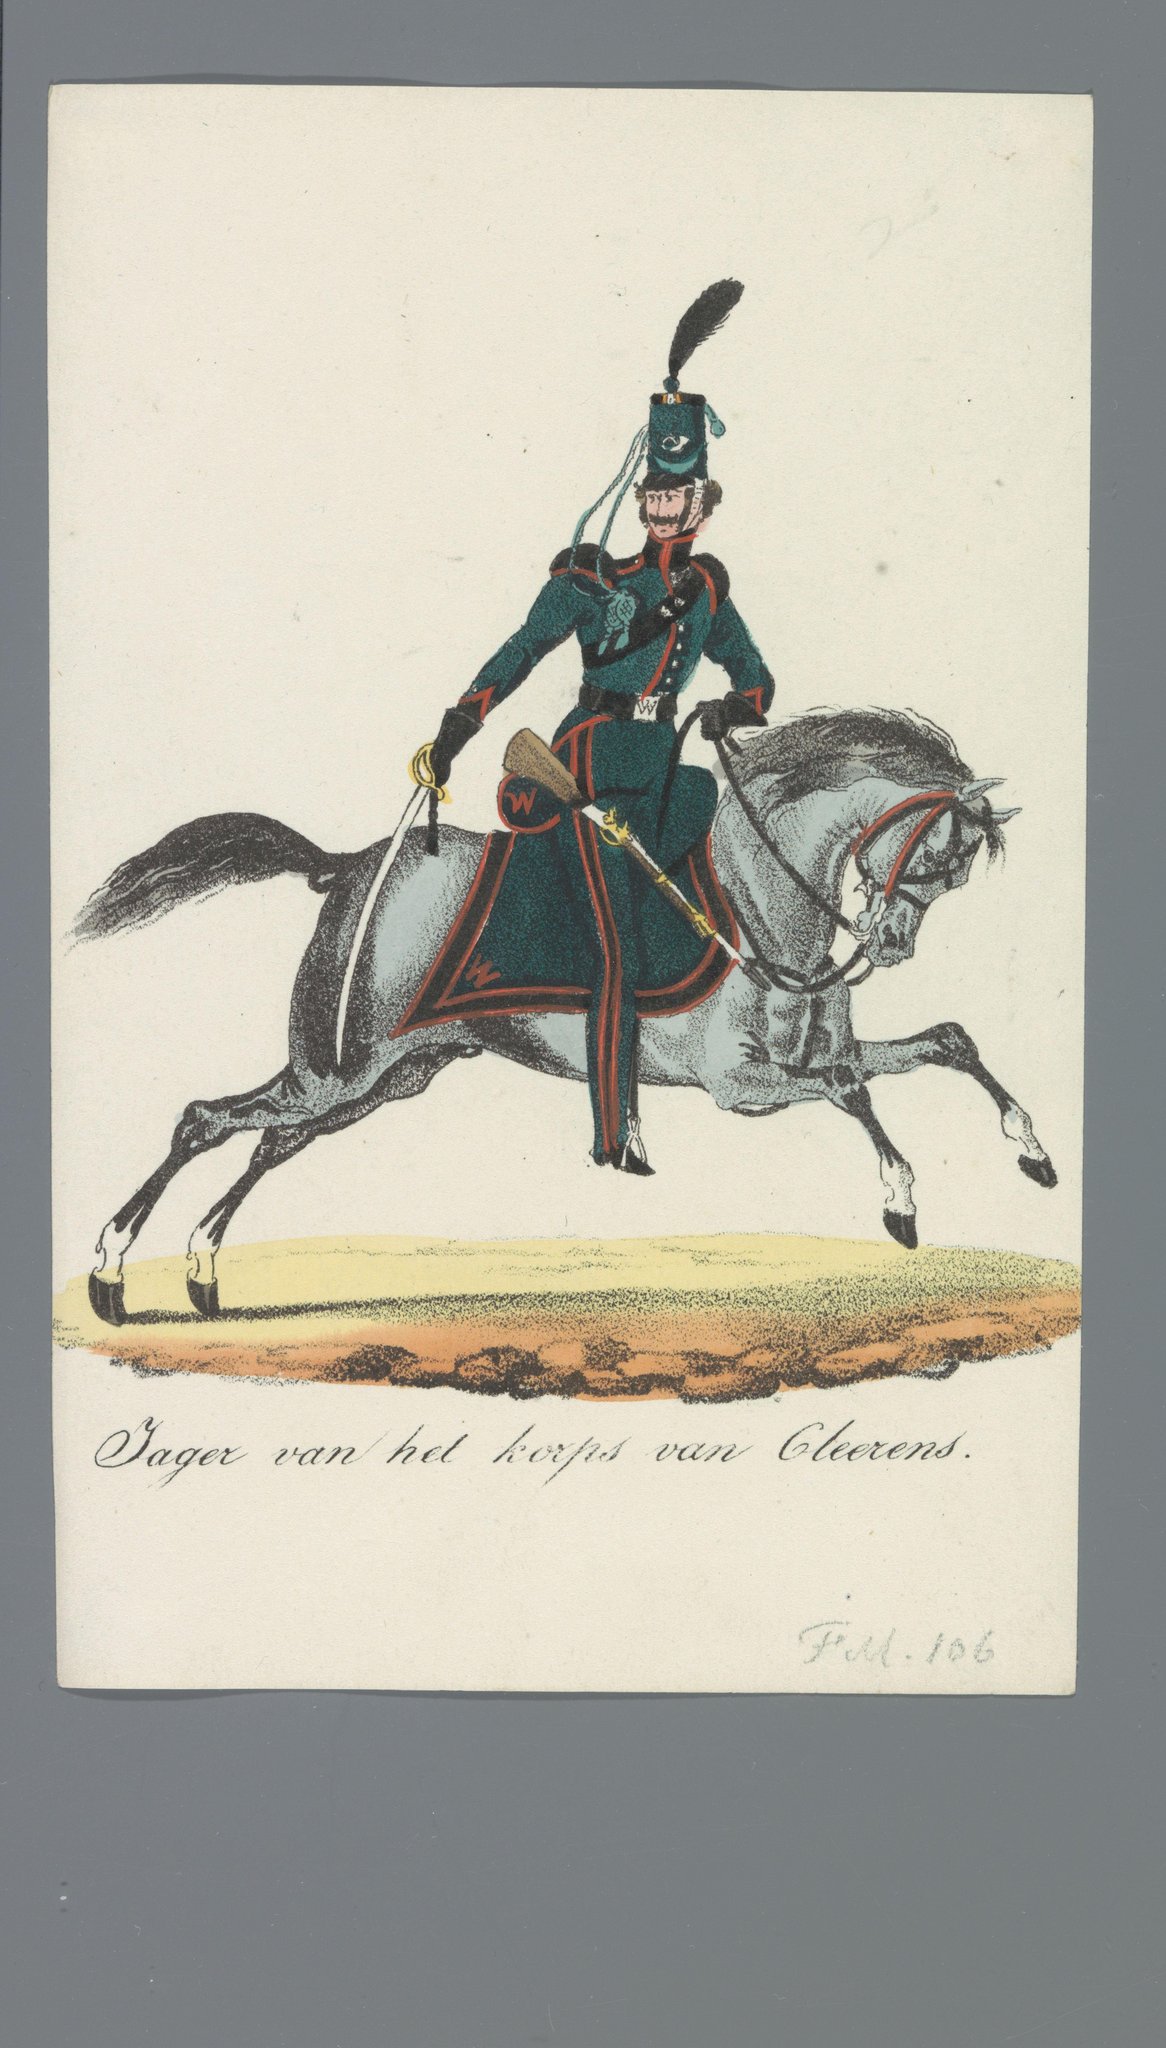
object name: costume print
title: Jager van het Korps van Cleerens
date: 1835-1850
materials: paper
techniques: hand coloring, lithograph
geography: utrecht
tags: (military) uniforms, clothes, costume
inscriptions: collector's mark: Lugt 2228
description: Een jager van het Korps Jagers van Cleerens, te paard. Onderdeel van een serie van 157 losse bladen met Nederlandse militaire uniformen in de jaren 1830-1832.